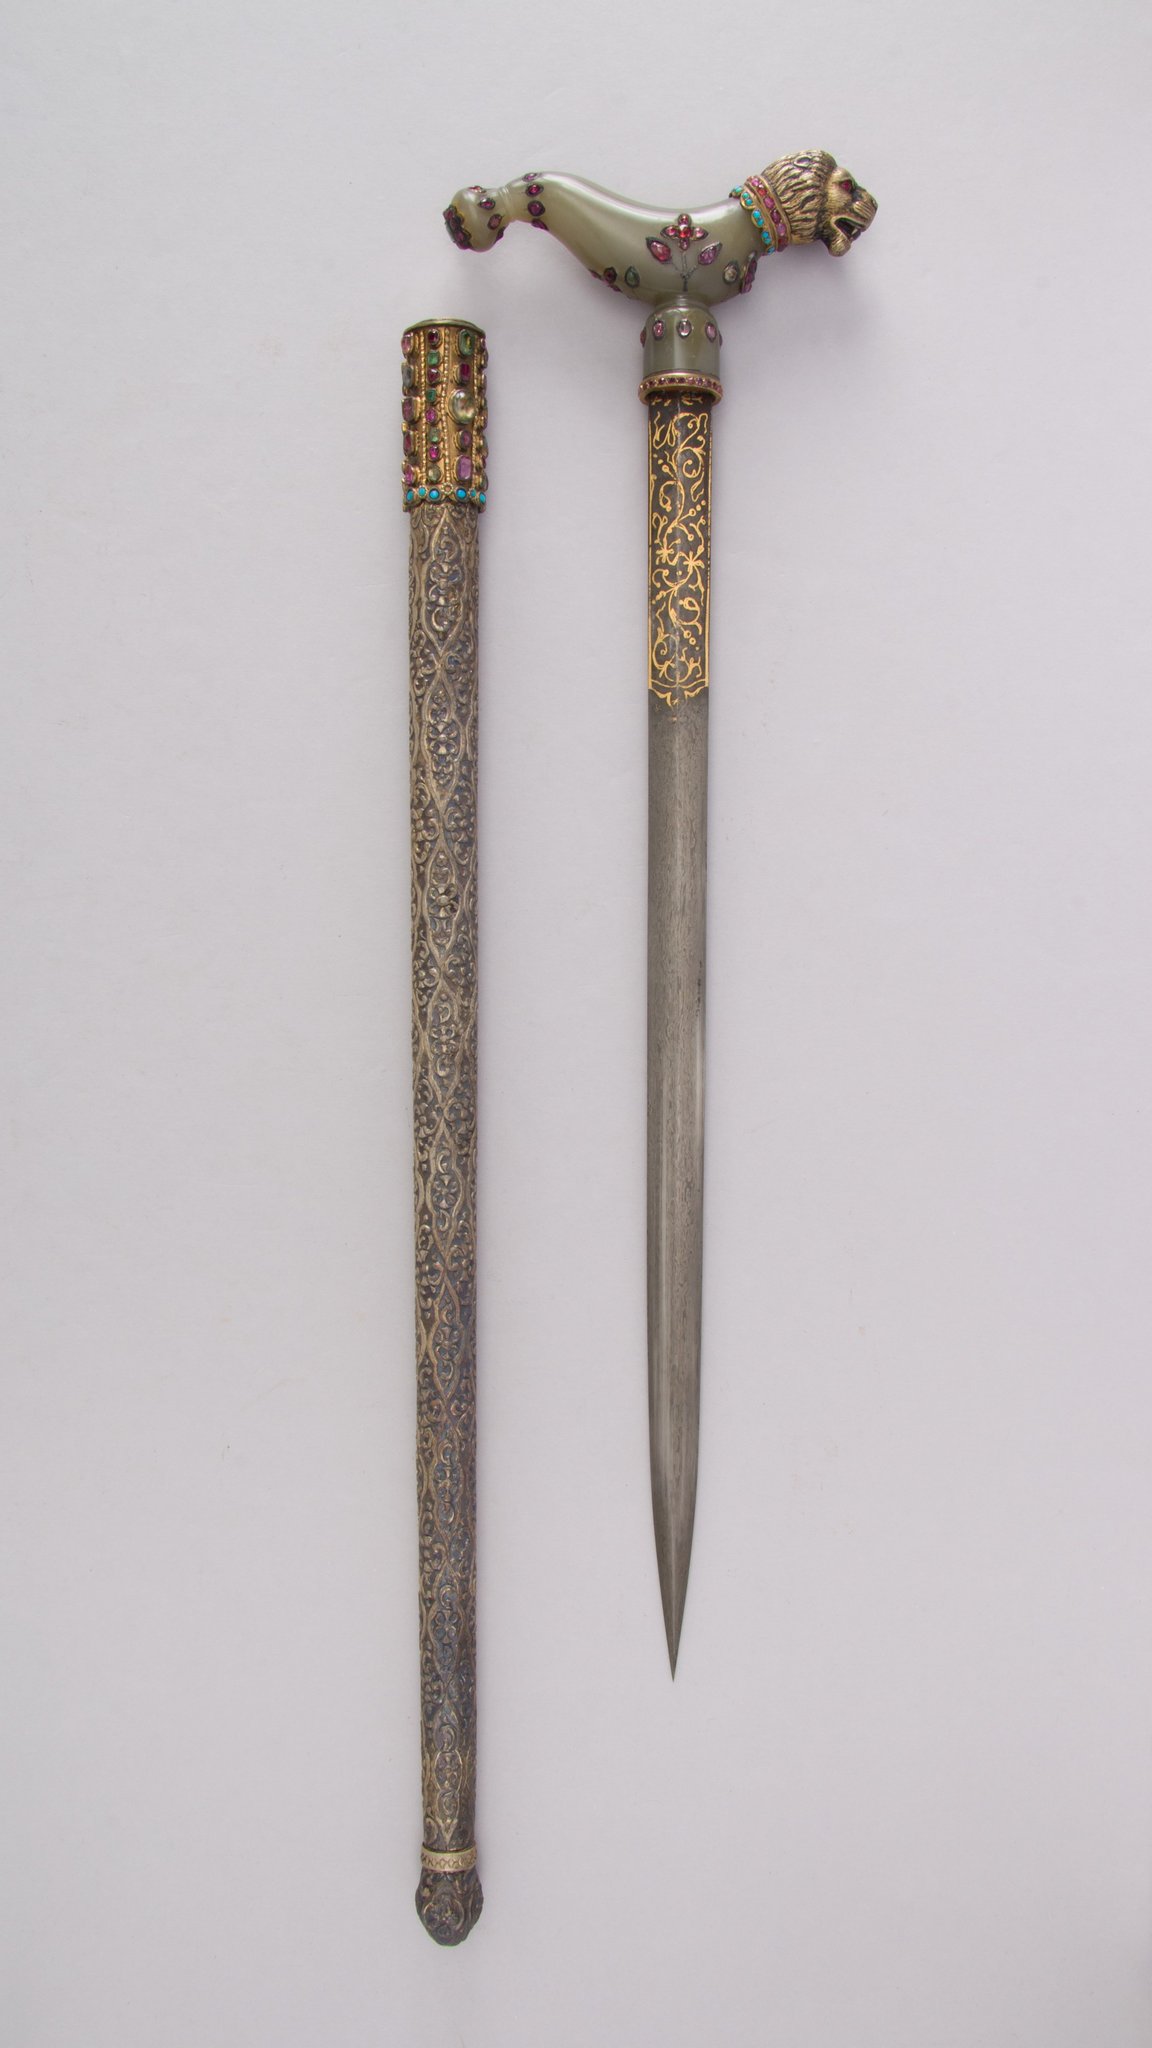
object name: crutch dagger zafar takieh with sheath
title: Crutch Dagger (Zafar Takieh, "Cushion of Victory") with Sheath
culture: indian, mughal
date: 1701-1900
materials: gemstone, gold, jade, silver, steel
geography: india